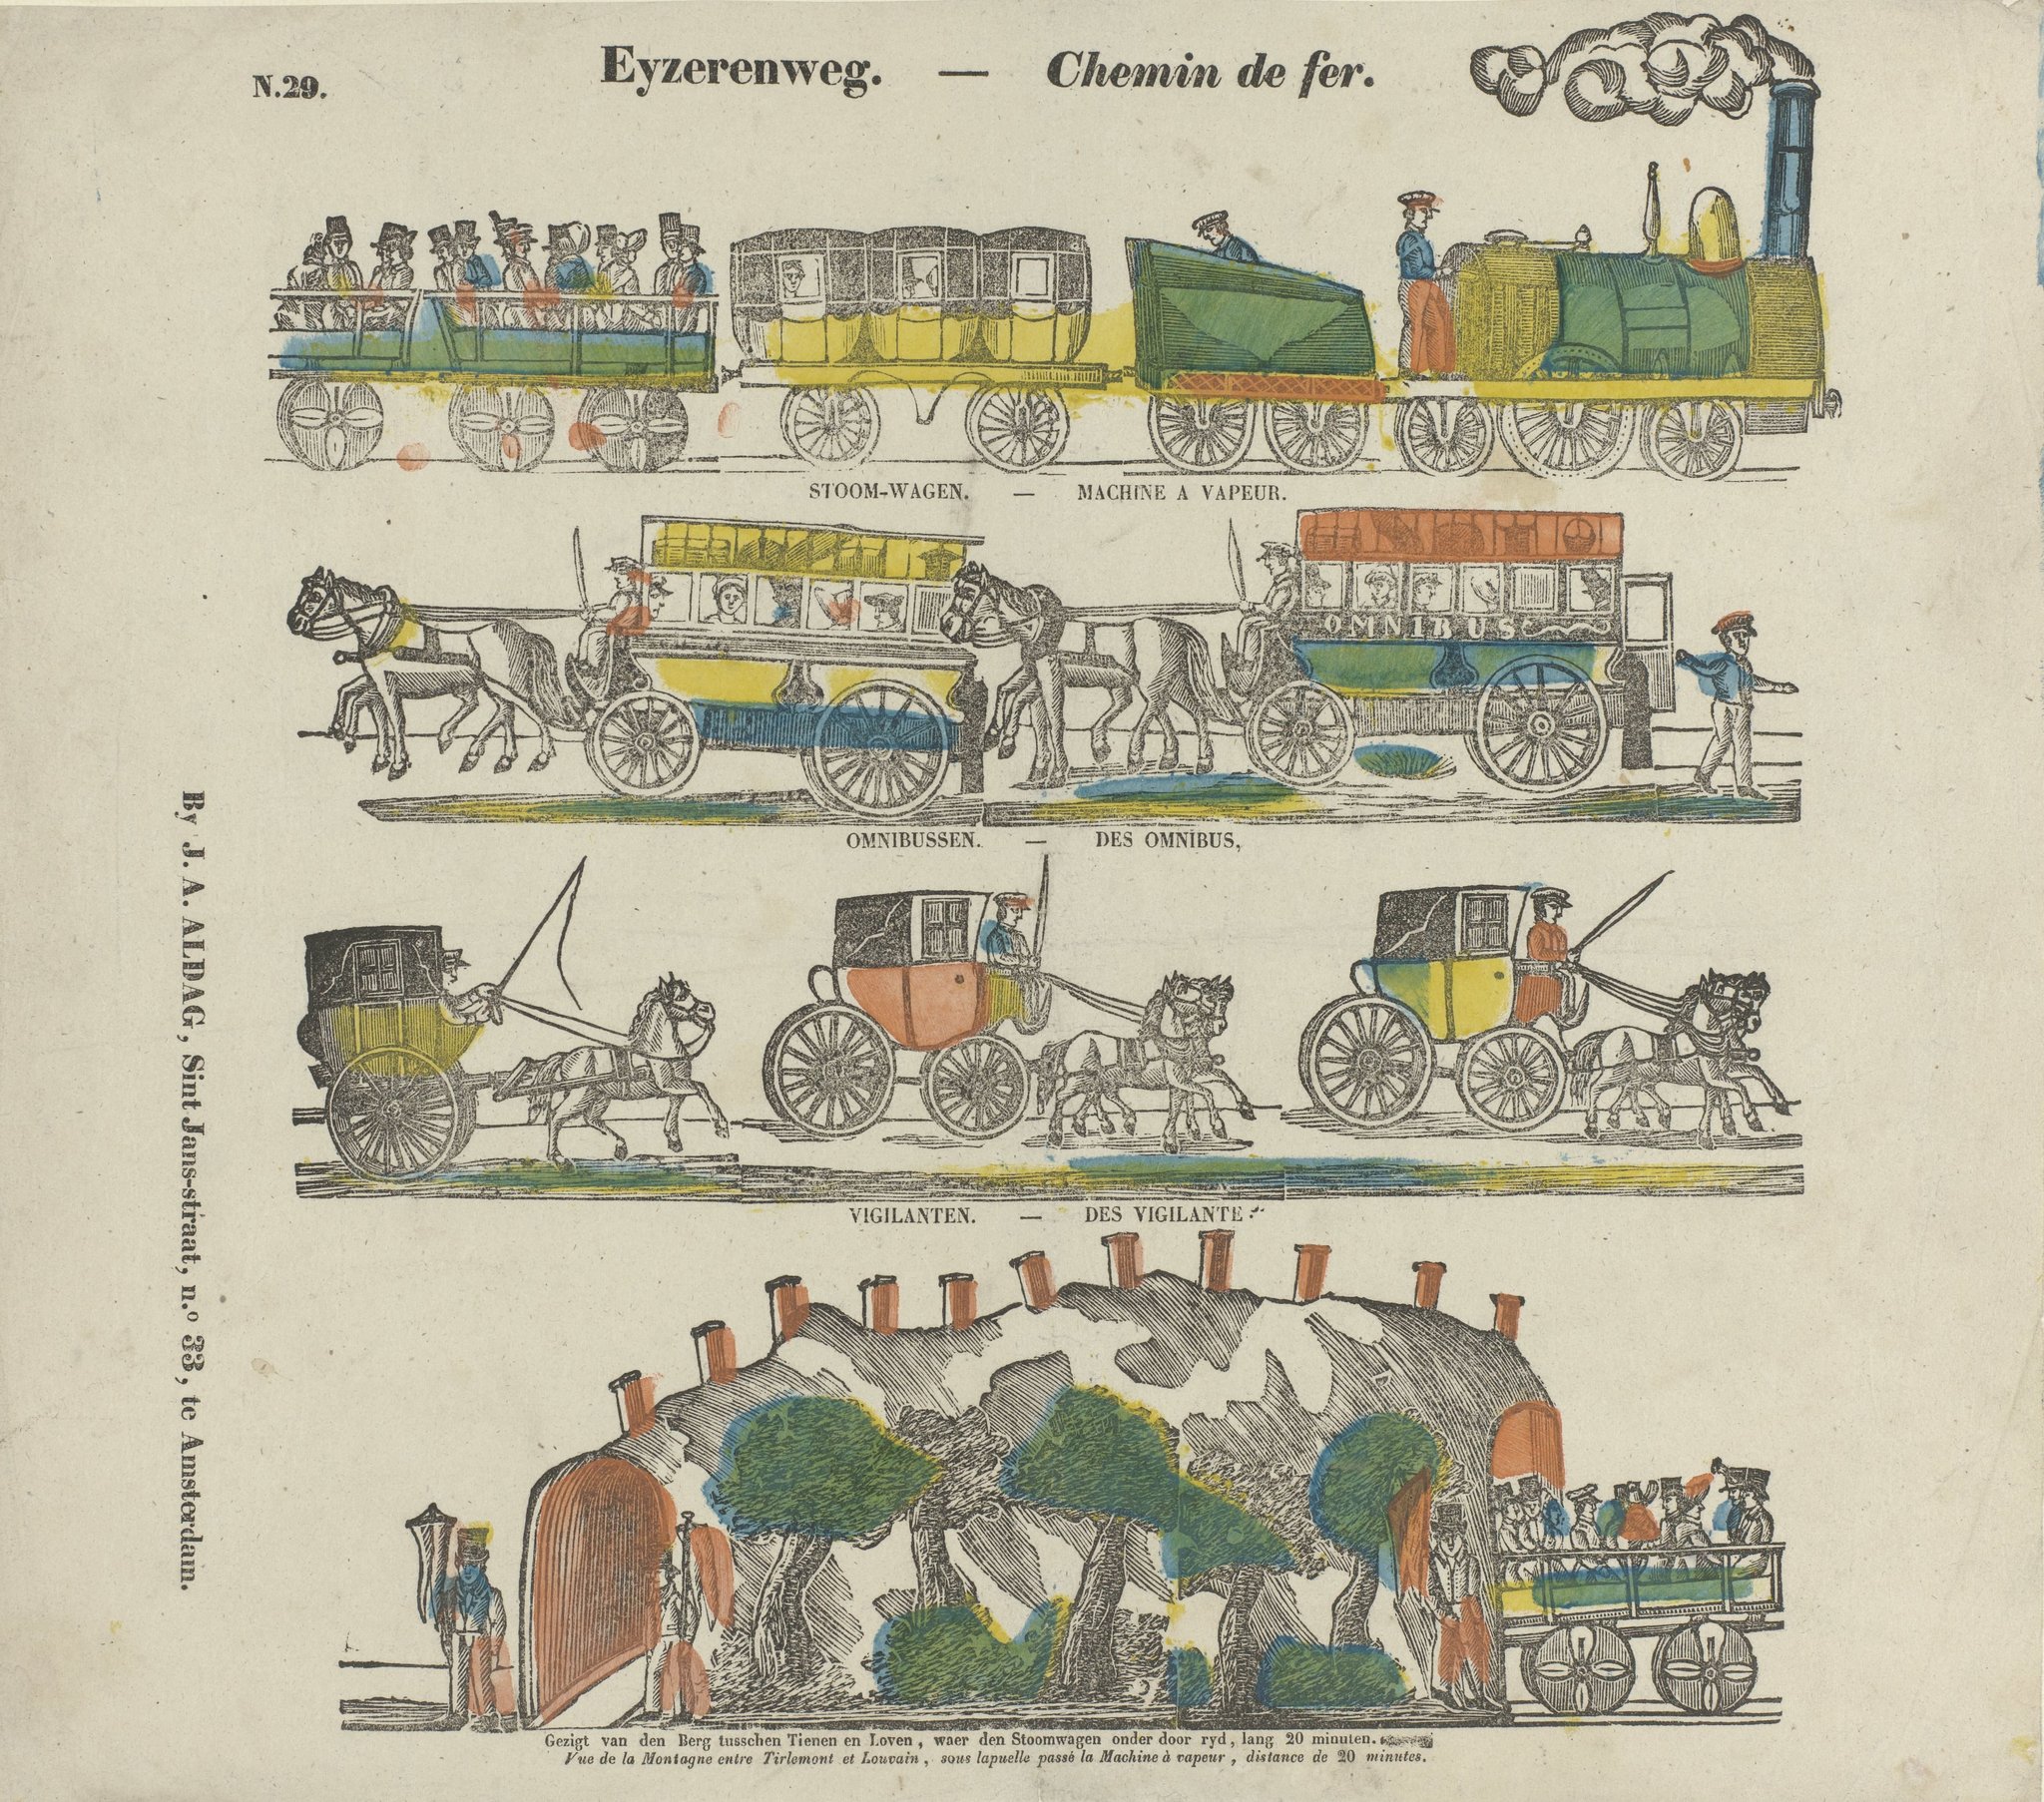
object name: print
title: Eyzerenweg - Chemin de fer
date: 1851-1880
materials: paper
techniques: colour, letterpress printing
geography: amsterdam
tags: passenger train, four-wheeled, animal-drawn vehicle, e.g.: cab, carriage, coach, railway, train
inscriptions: collector's mark: Lugt 2760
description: Blad met 4 horizontale rijen met voertuigen, waaronder een stoomtrein, omnibussen en paard en wagen. Beneden een trein die door een tunnel gaat. Onder elke voorstelling een onderschrift in het Nederlands en het Frans. Genummerd linksboven: N 29.